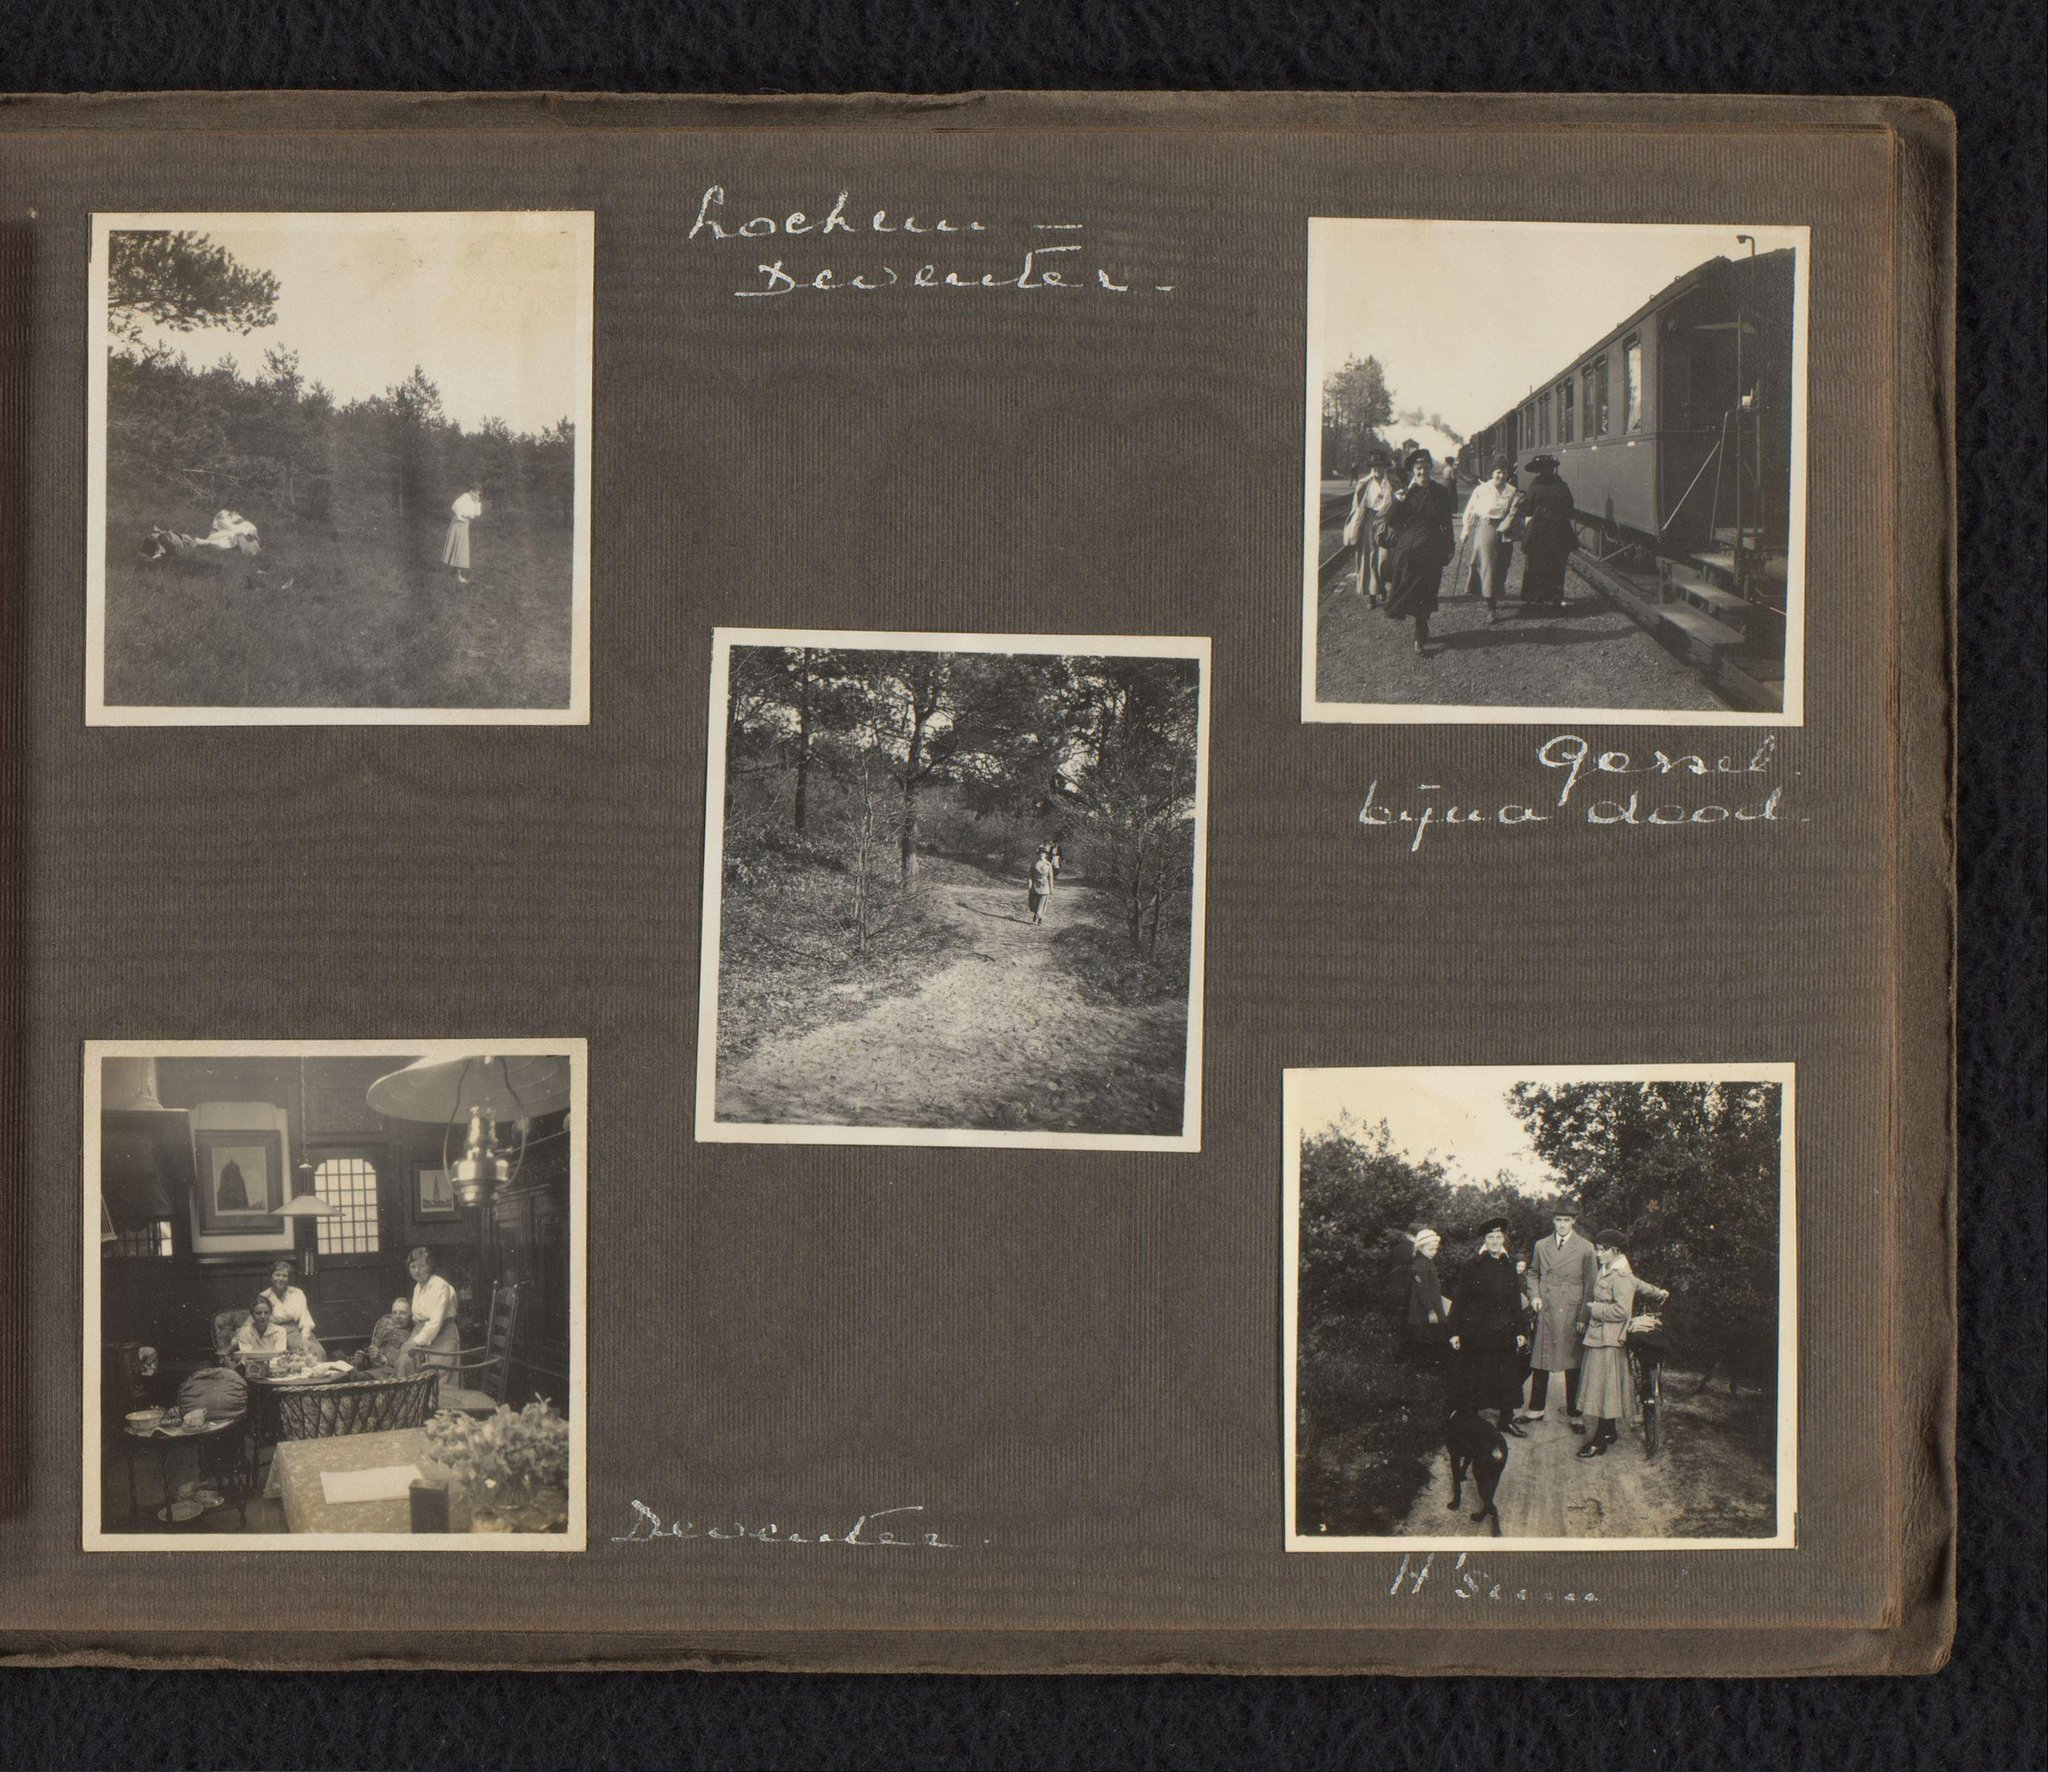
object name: photograph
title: Vijf foto's van familie Onnen-Van den Berg tijdens een wandeling bij Lochem en Deventer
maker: Anonymous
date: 1904-1917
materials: paper, cardboard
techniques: gelatin silver print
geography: lochem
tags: walking, hiking (recreation), passenger train, family life, forest path or lane, interior ~ representation of a building, dog, deventer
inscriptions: caption: ‘Lochem/ Deventer./ Gorsel./ bijna dood./ Deventer./ H'sum.’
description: Deze foto's maken deel uit van een album.